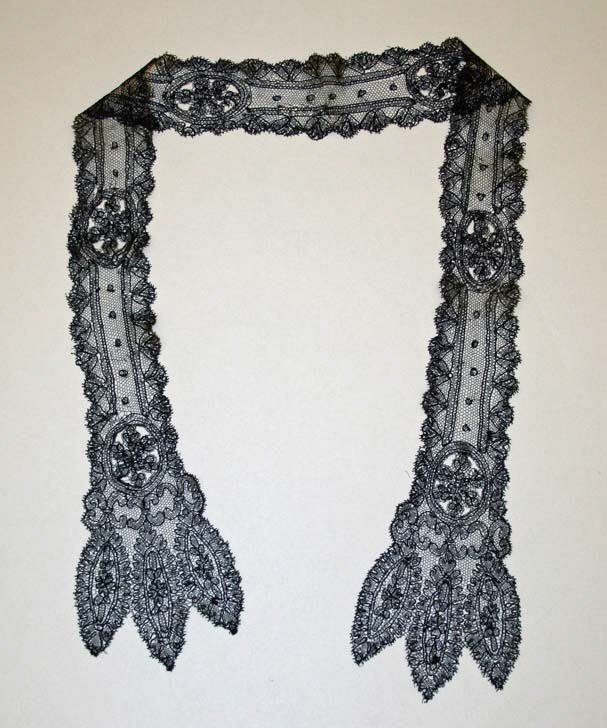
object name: barbe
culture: american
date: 1870-1892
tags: flowers